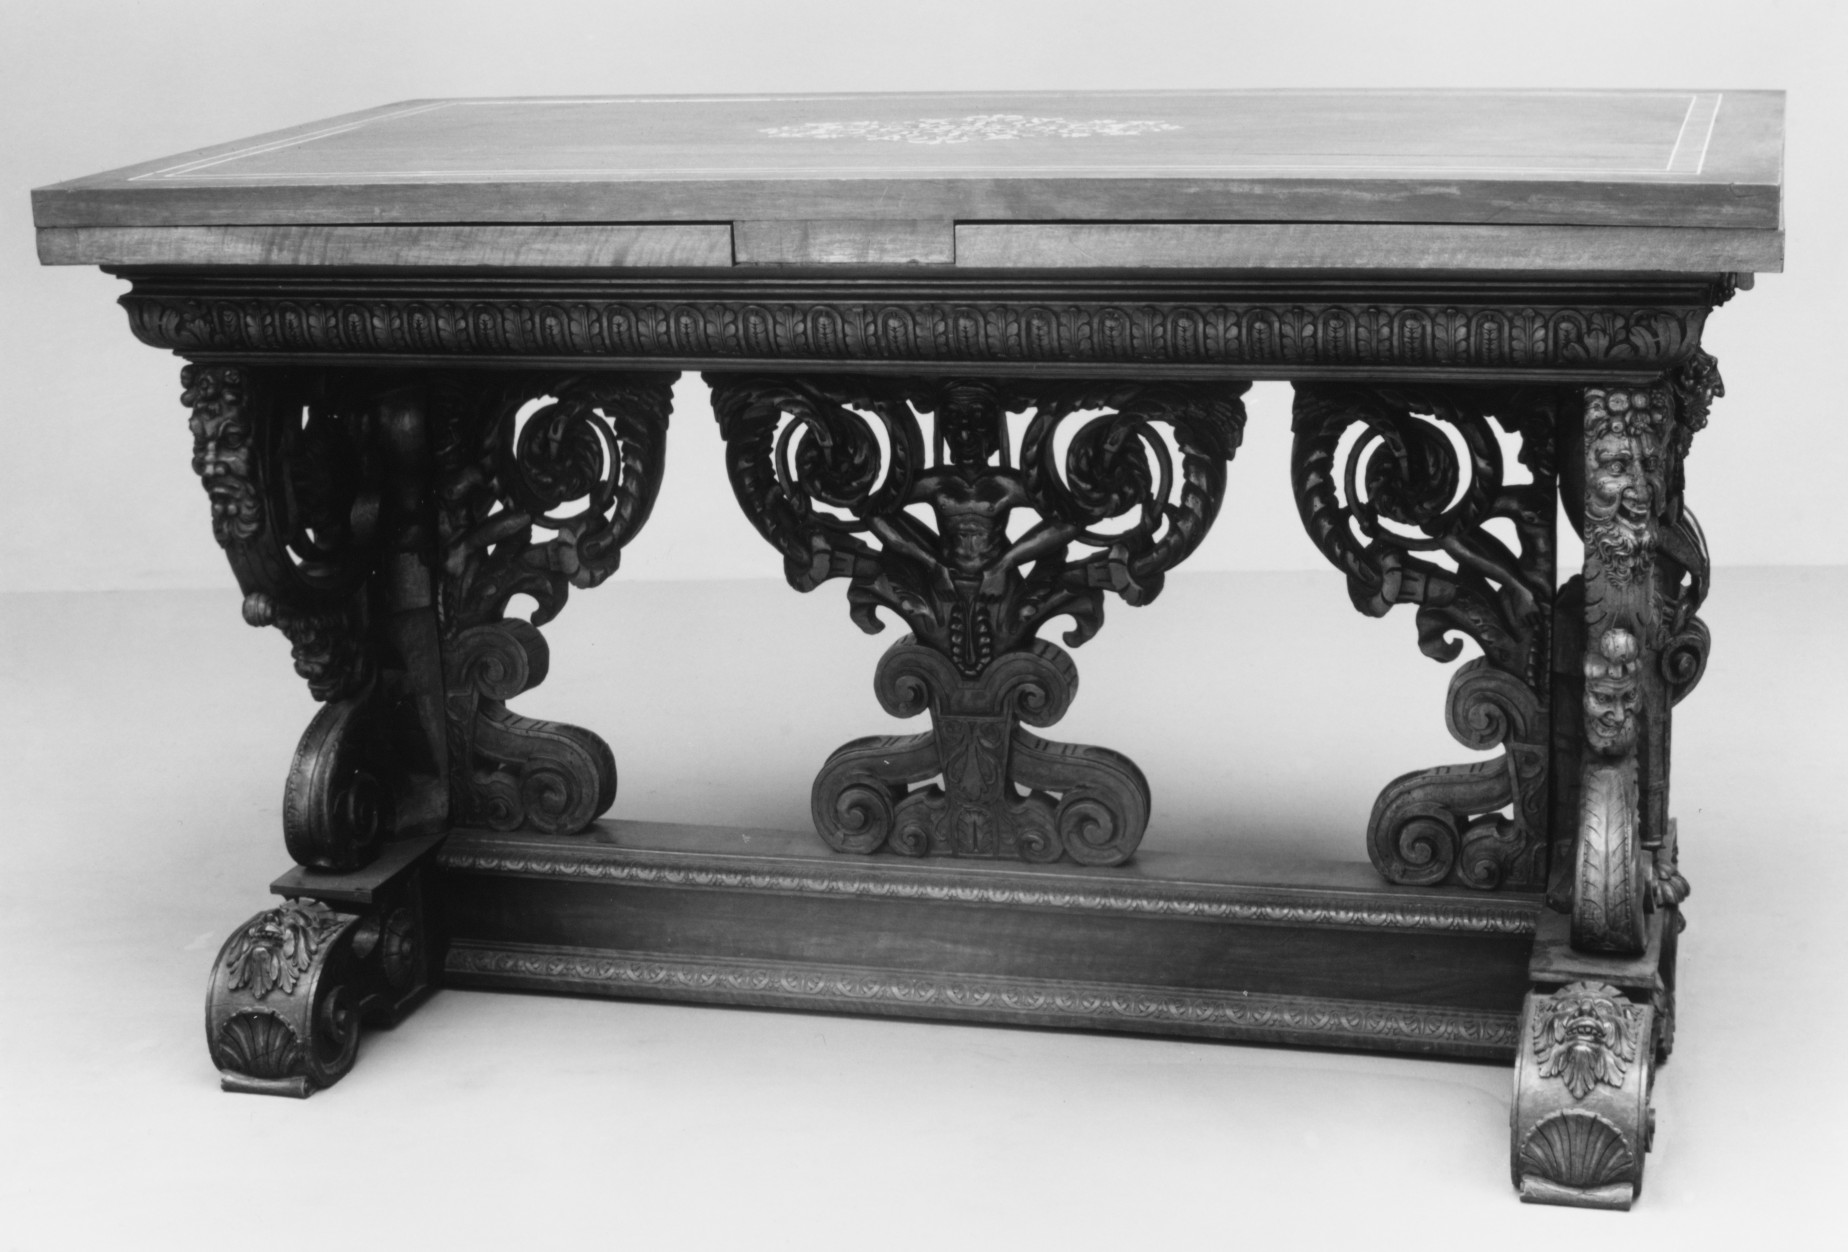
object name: draw top table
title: Draw-top table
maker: jacques androuet du cerceau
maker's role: designer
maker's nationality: french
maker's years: 1510-1585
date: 1820-1850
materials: ivory, wood